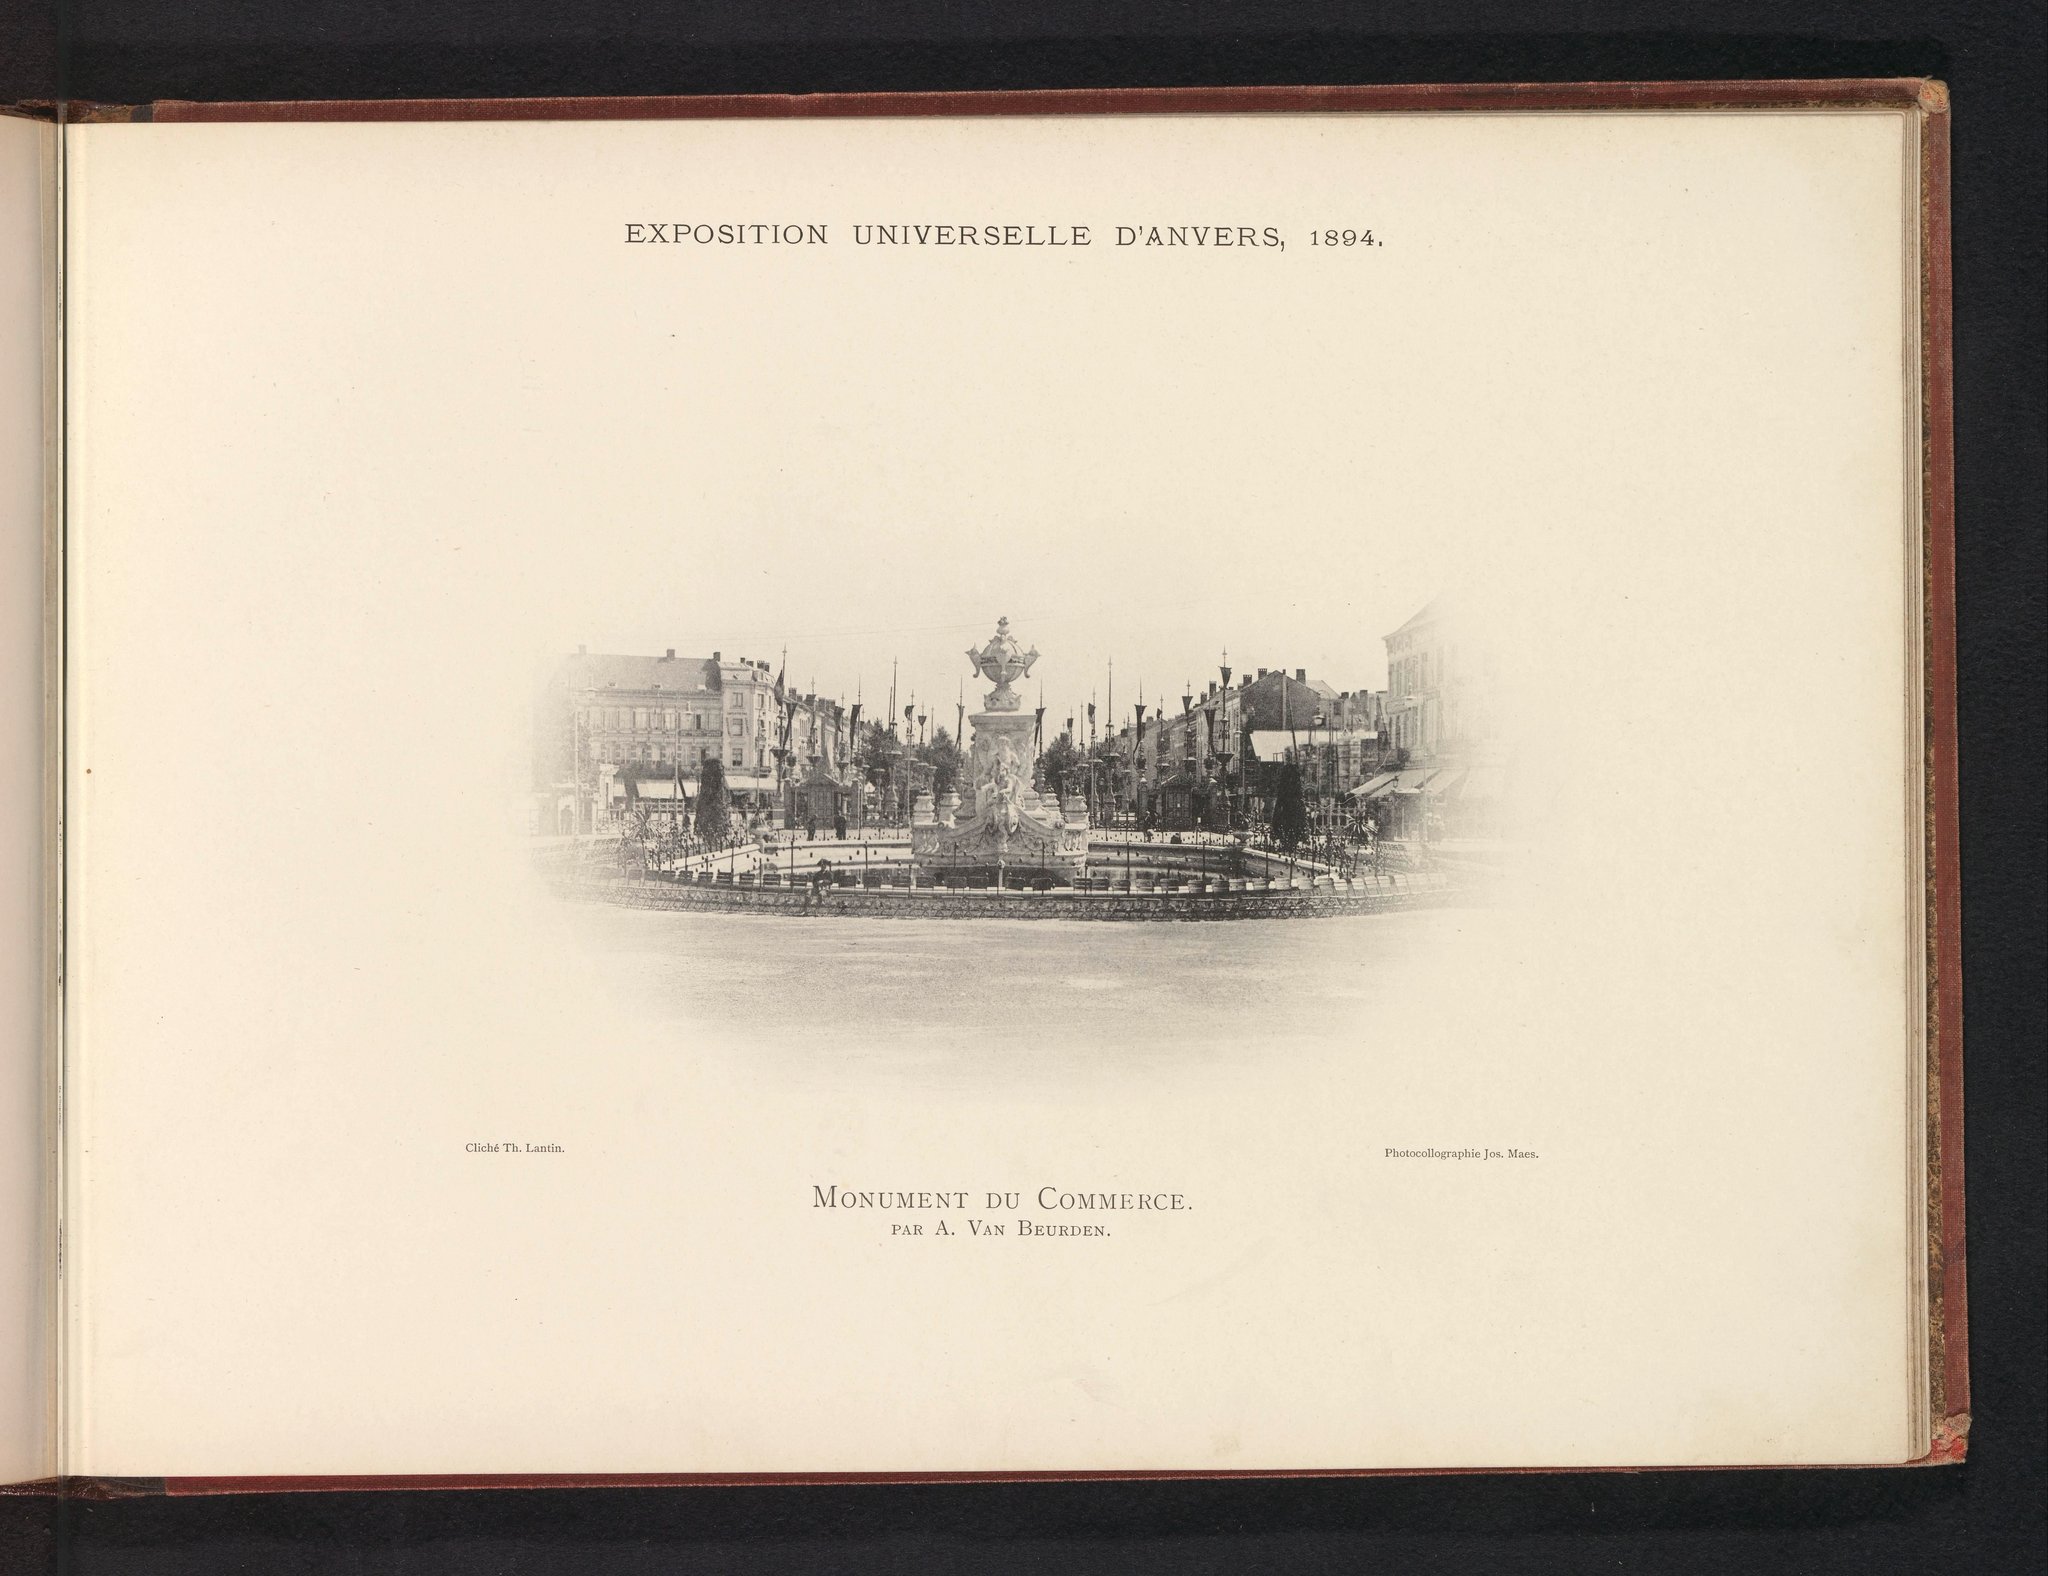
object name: page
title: Monument du commerce, par A. van Beurden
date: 1890-1894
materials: paper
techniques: photograph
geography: antwerp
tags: monument, statue